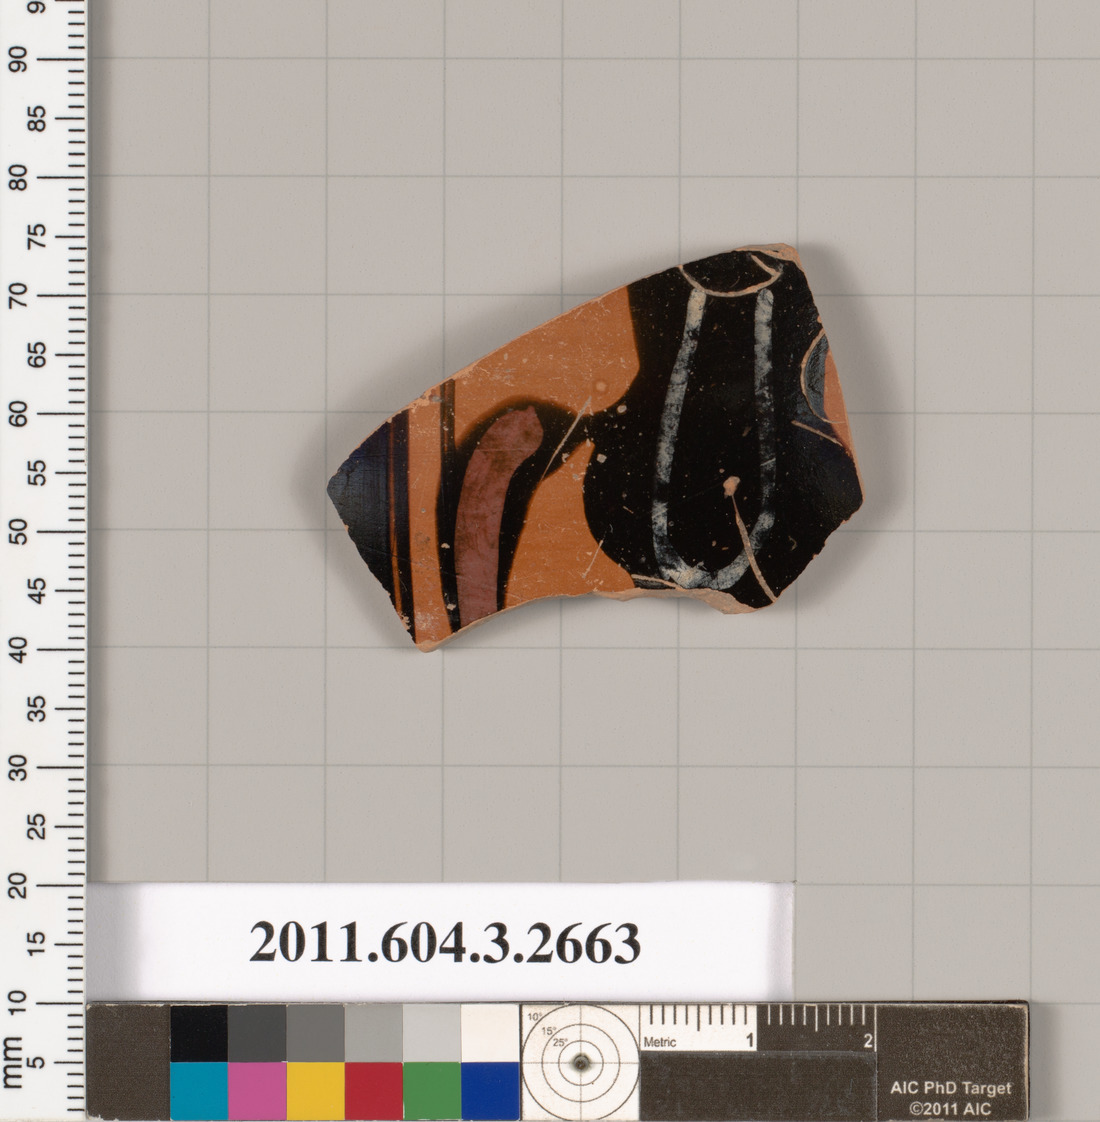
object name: olpe fragment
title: Terracotta fragment of an olpe (jug)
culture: greek, attic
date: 510-500 BCE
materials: terracotta